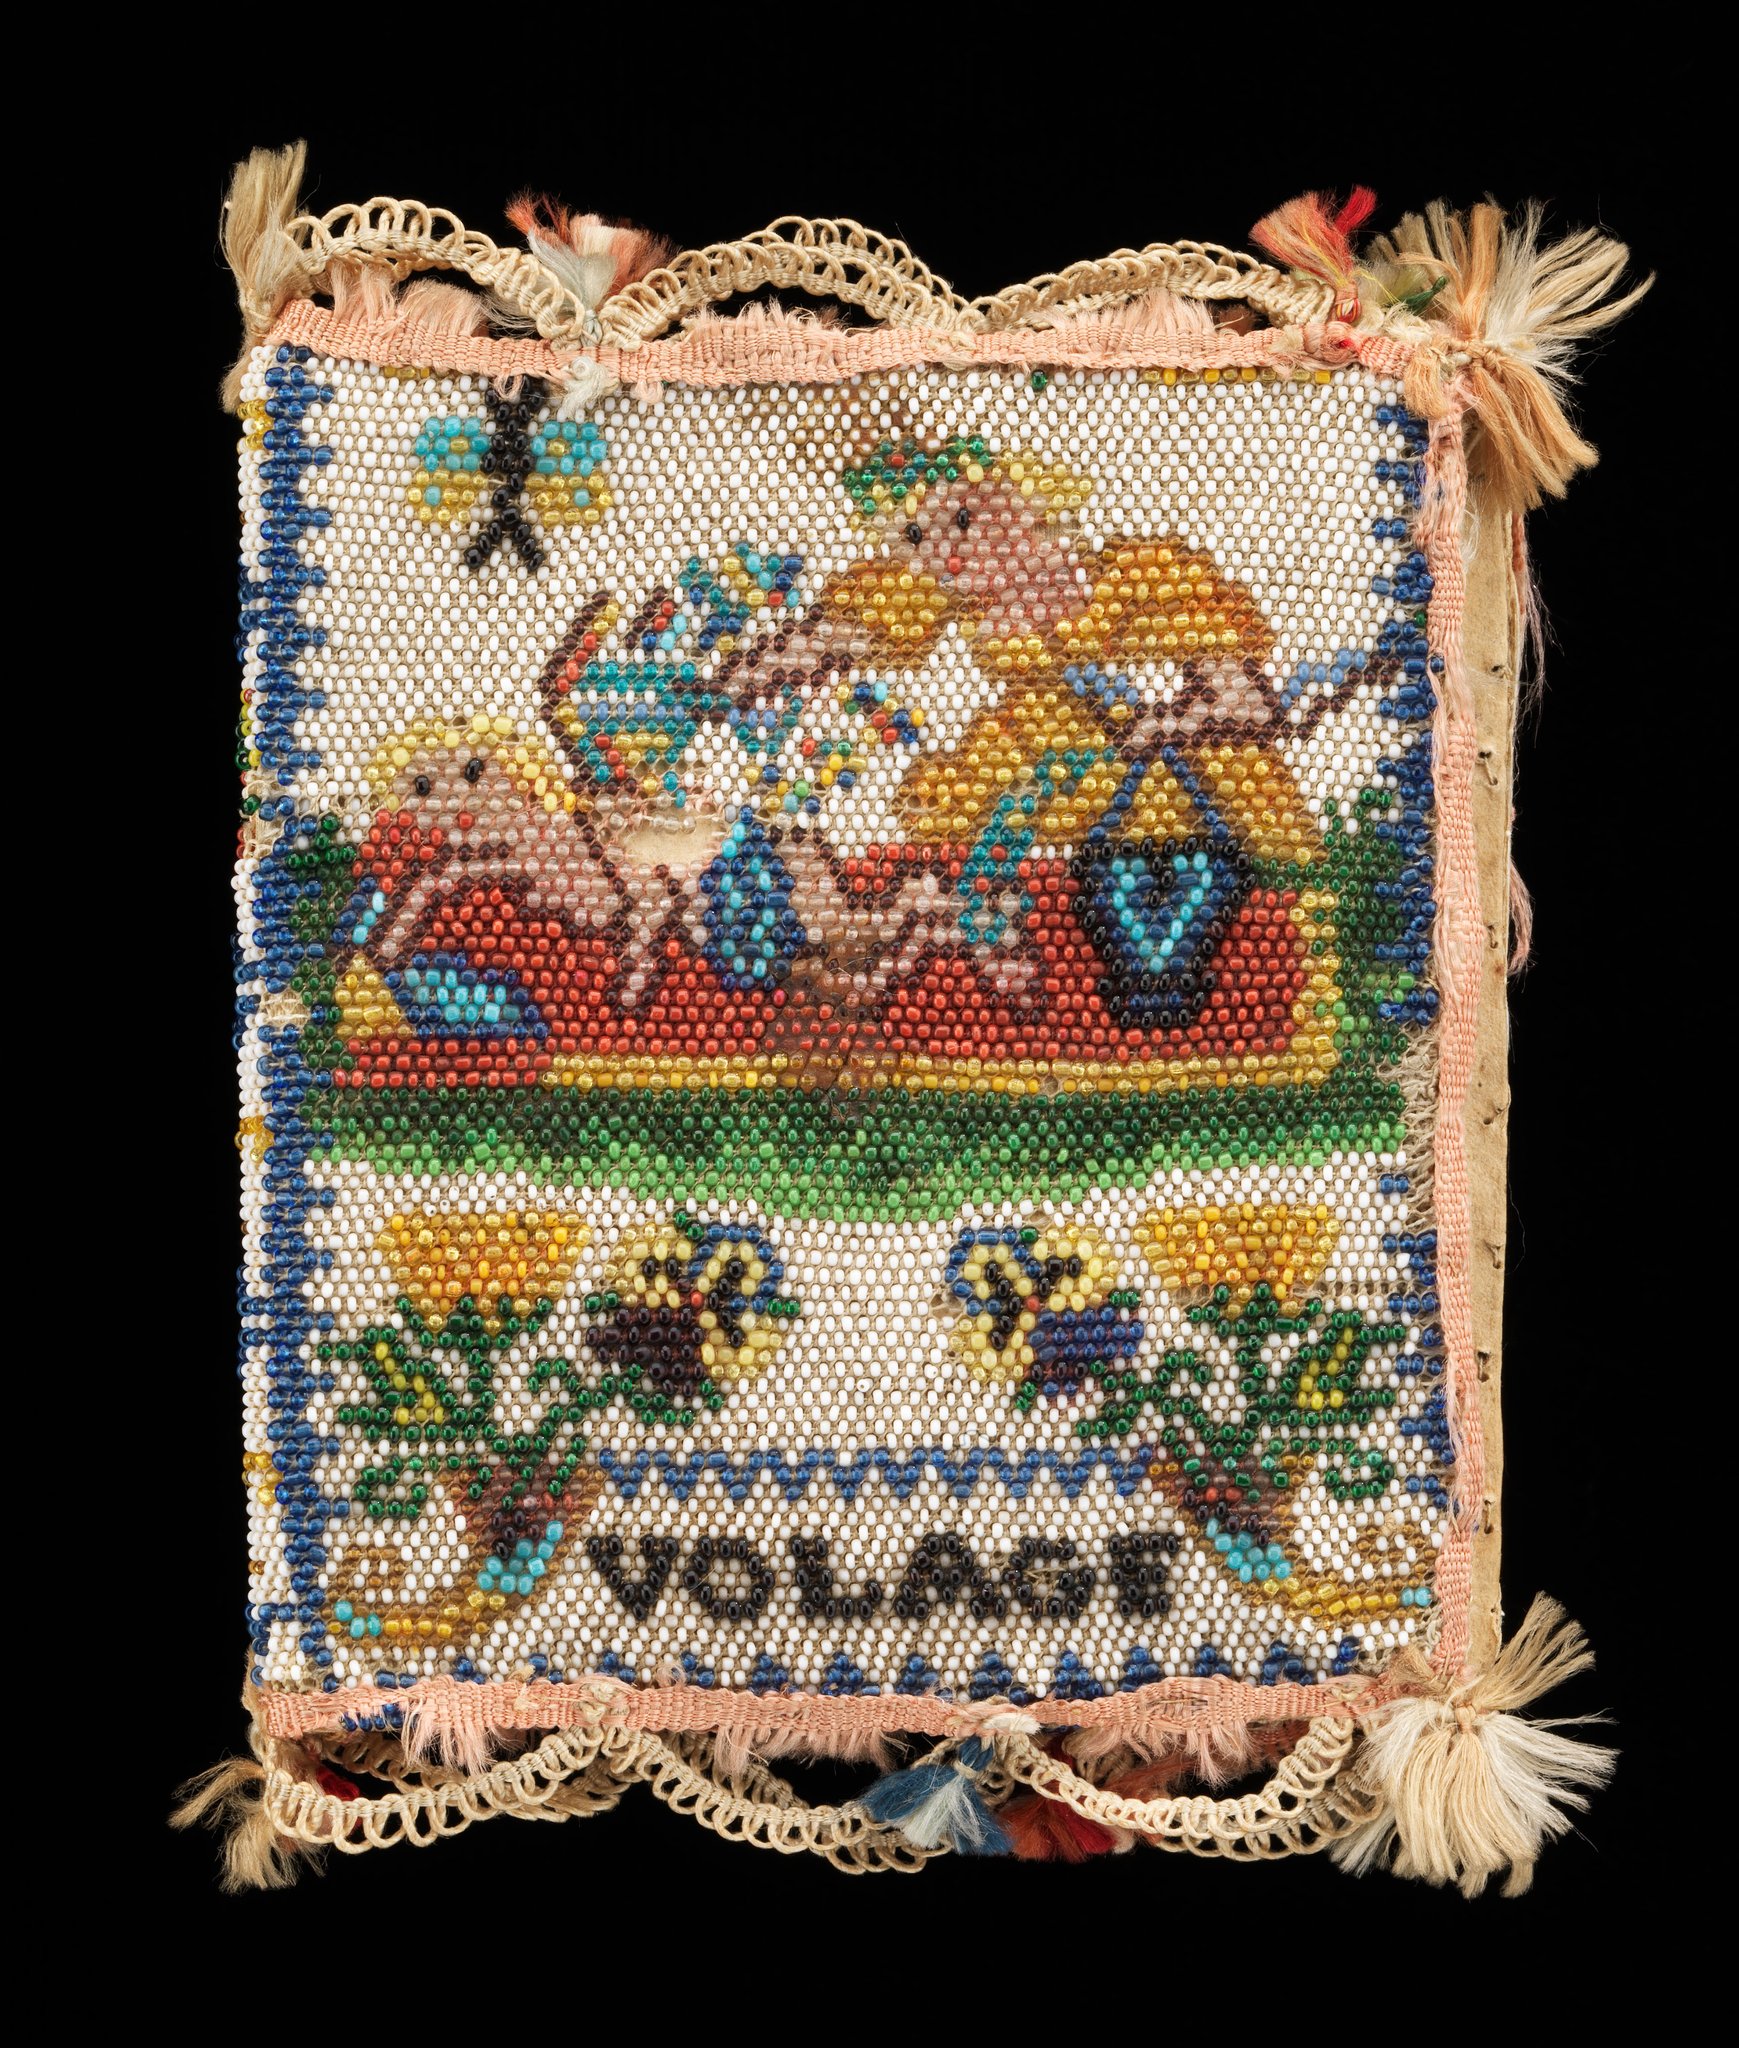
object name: accessory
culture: french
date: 1790-1810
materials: glass, silk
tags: women